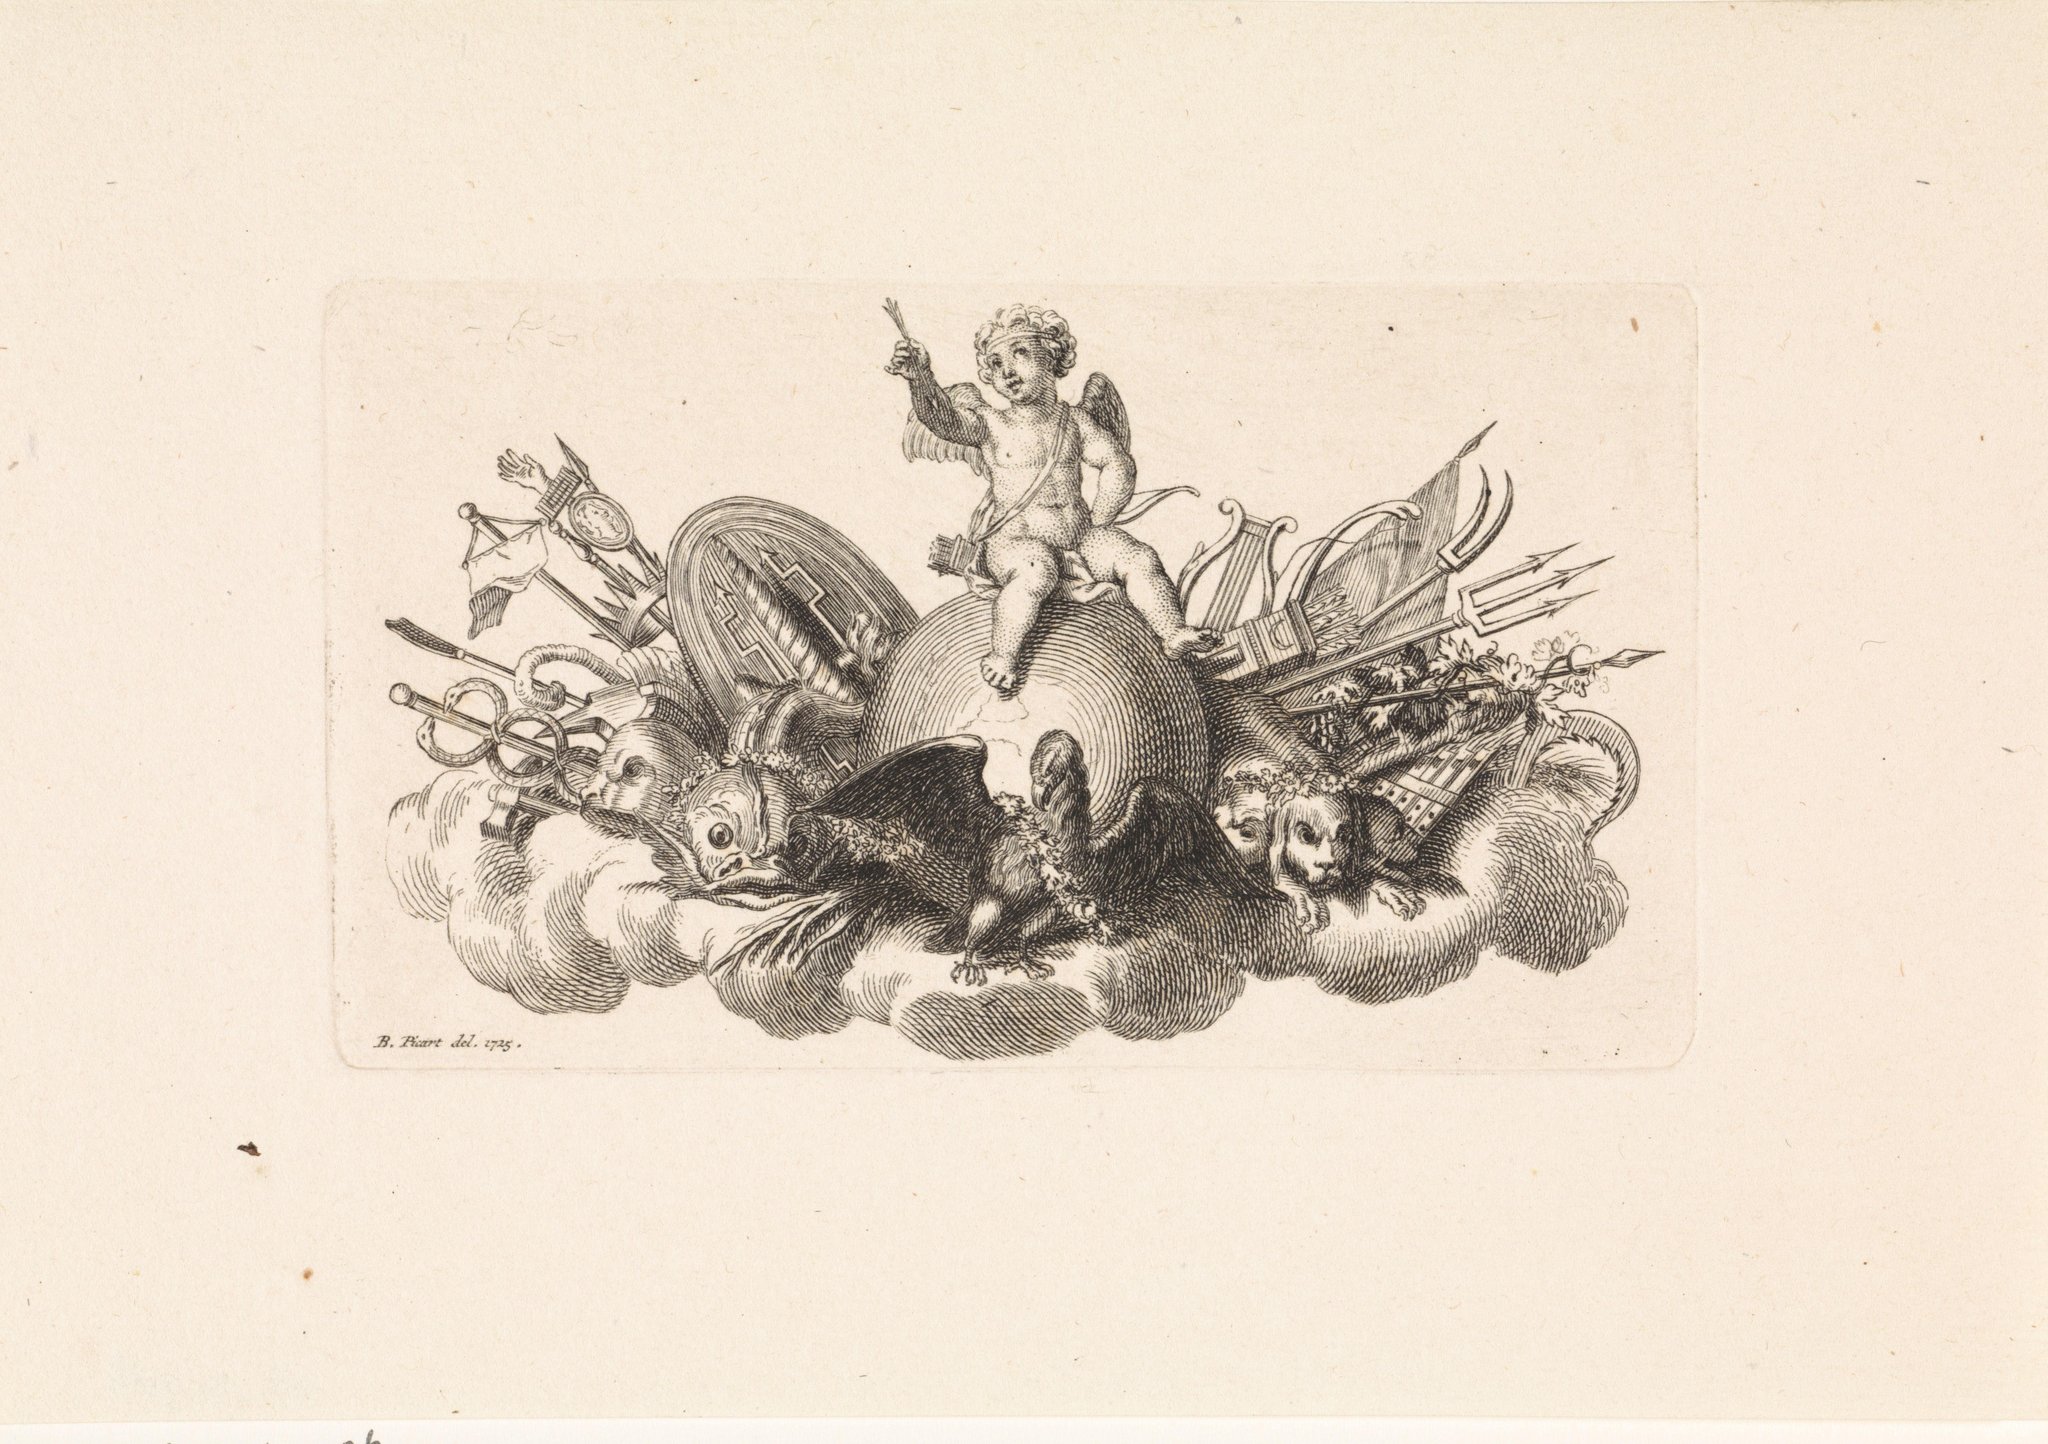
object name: print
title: Triomferende Amor zittend op de wereld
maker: bernard picart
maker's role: draughtsman, print maker, publisher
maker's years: 1673-1733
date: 1725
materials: paper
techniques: engraving, etching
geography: amsterdam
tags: 'omnia vincit amor', love the conqueror, love triumphant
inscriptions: collector's mark: Lugt 2228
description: Amor zit op de wereldbol en toont in triomf een pijl, ten teken dat liefde alles overwint. Rond de wereldbol verschillende wereldlijke attributen, zoals kronen, lansen, attributen van de verschillende kunsten en de driekoppige hellehond Cerberus.